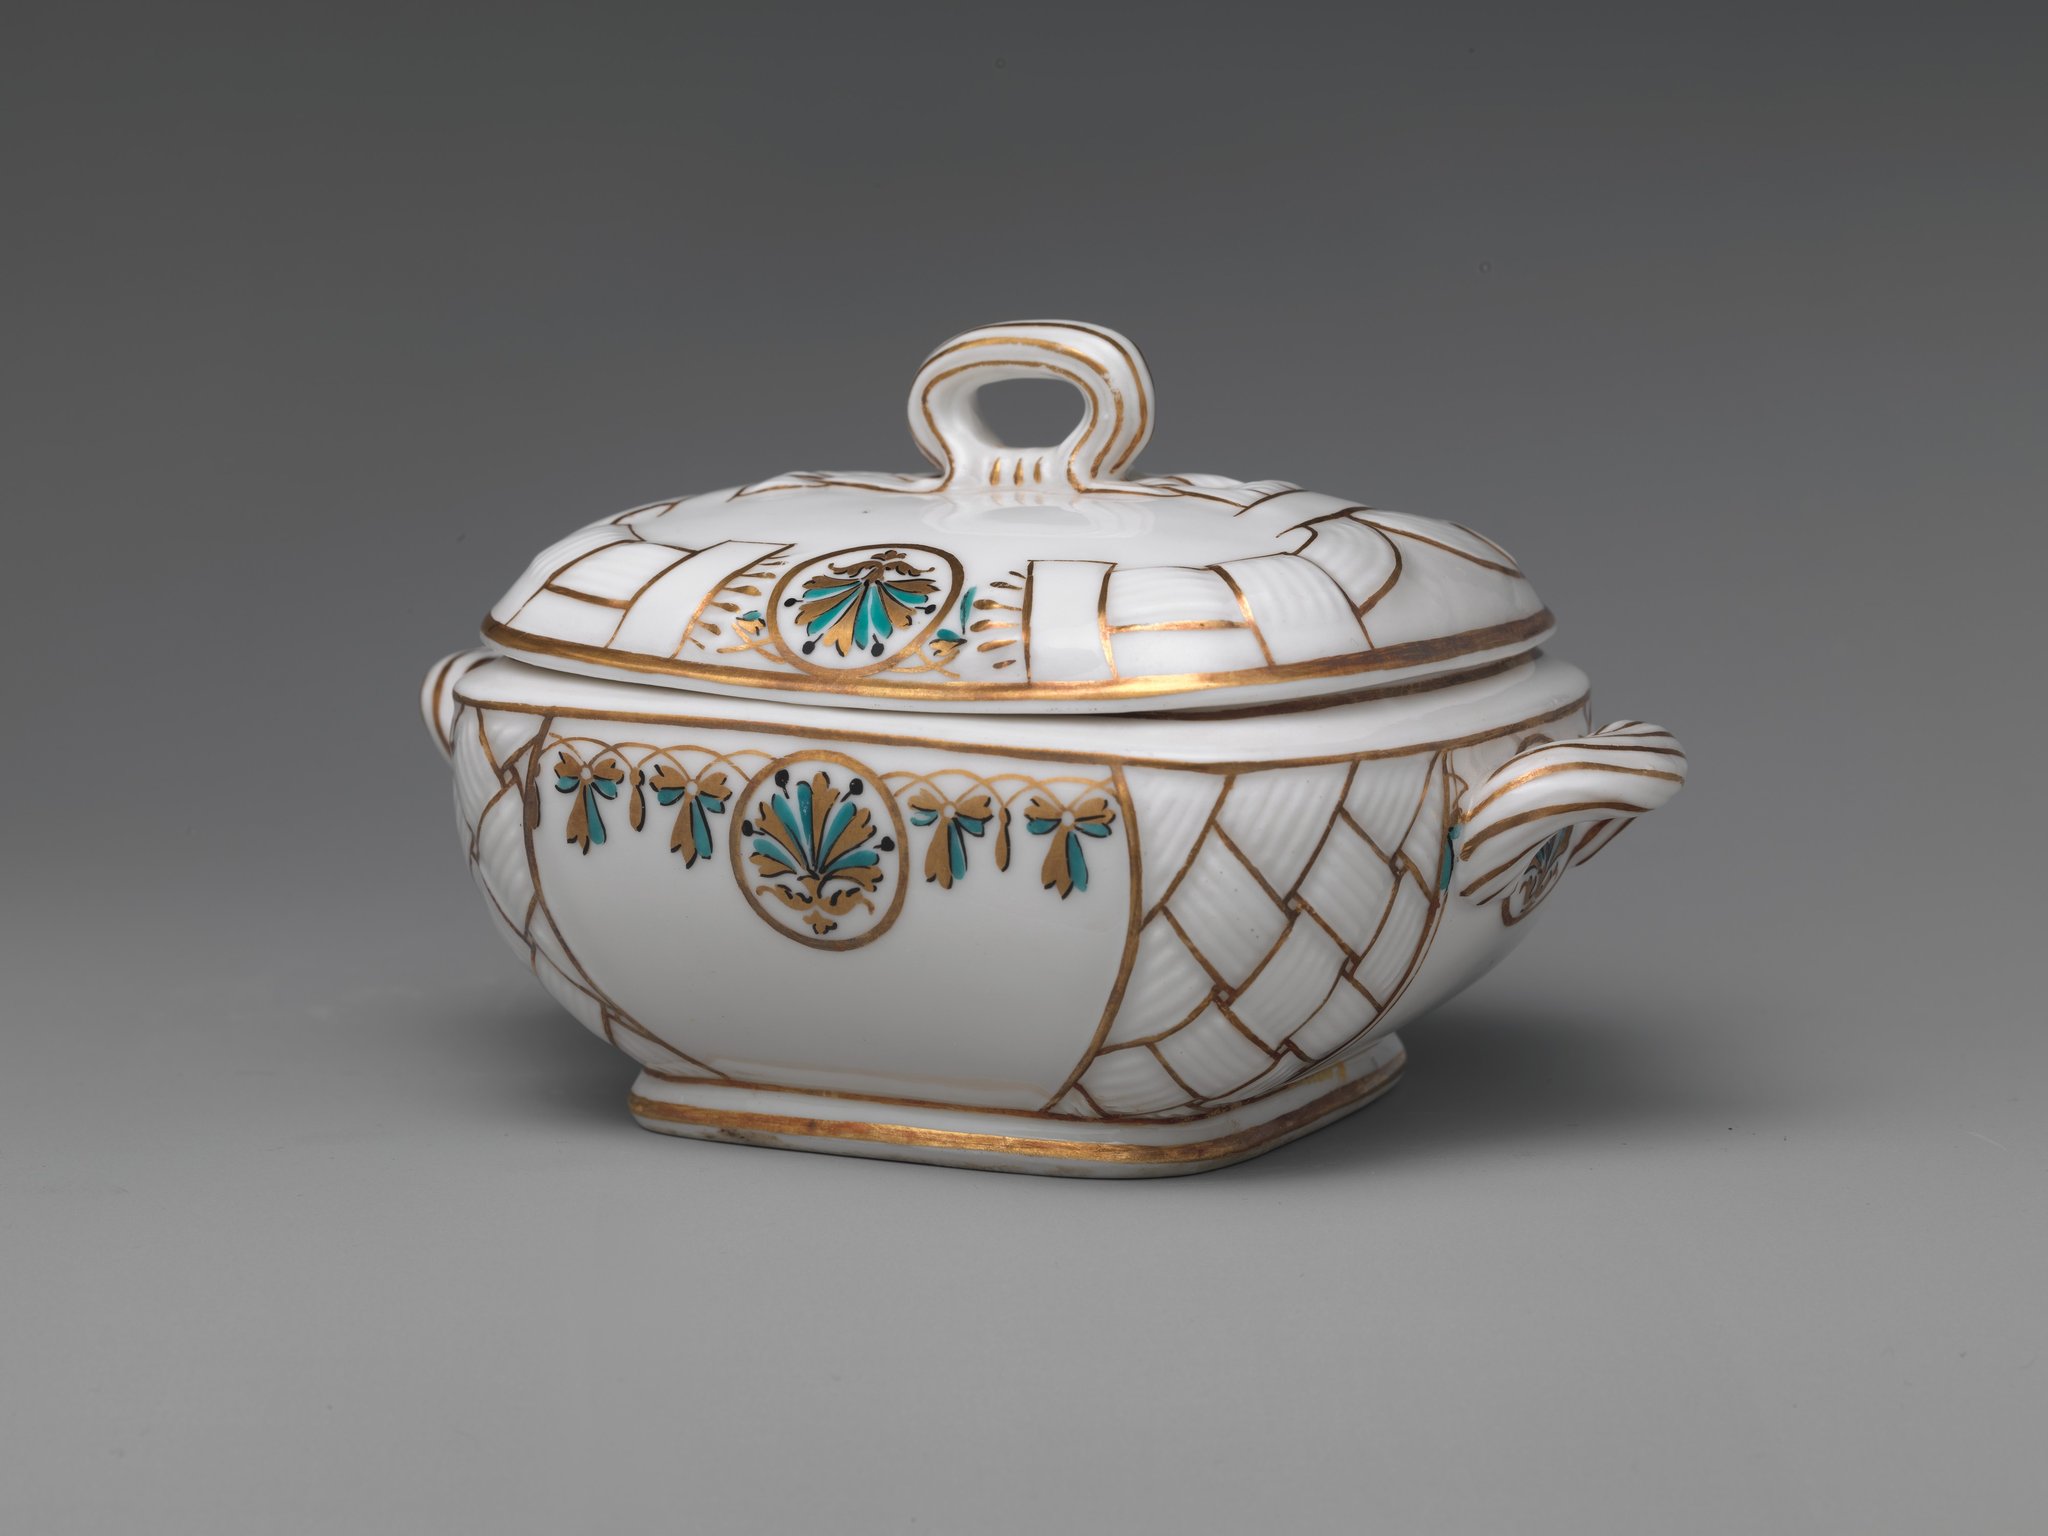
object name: sugar bowl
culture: american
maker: union porcelain works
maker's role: maker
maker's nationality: american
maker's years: 1863-1922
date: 1885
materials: porcelain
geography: united states